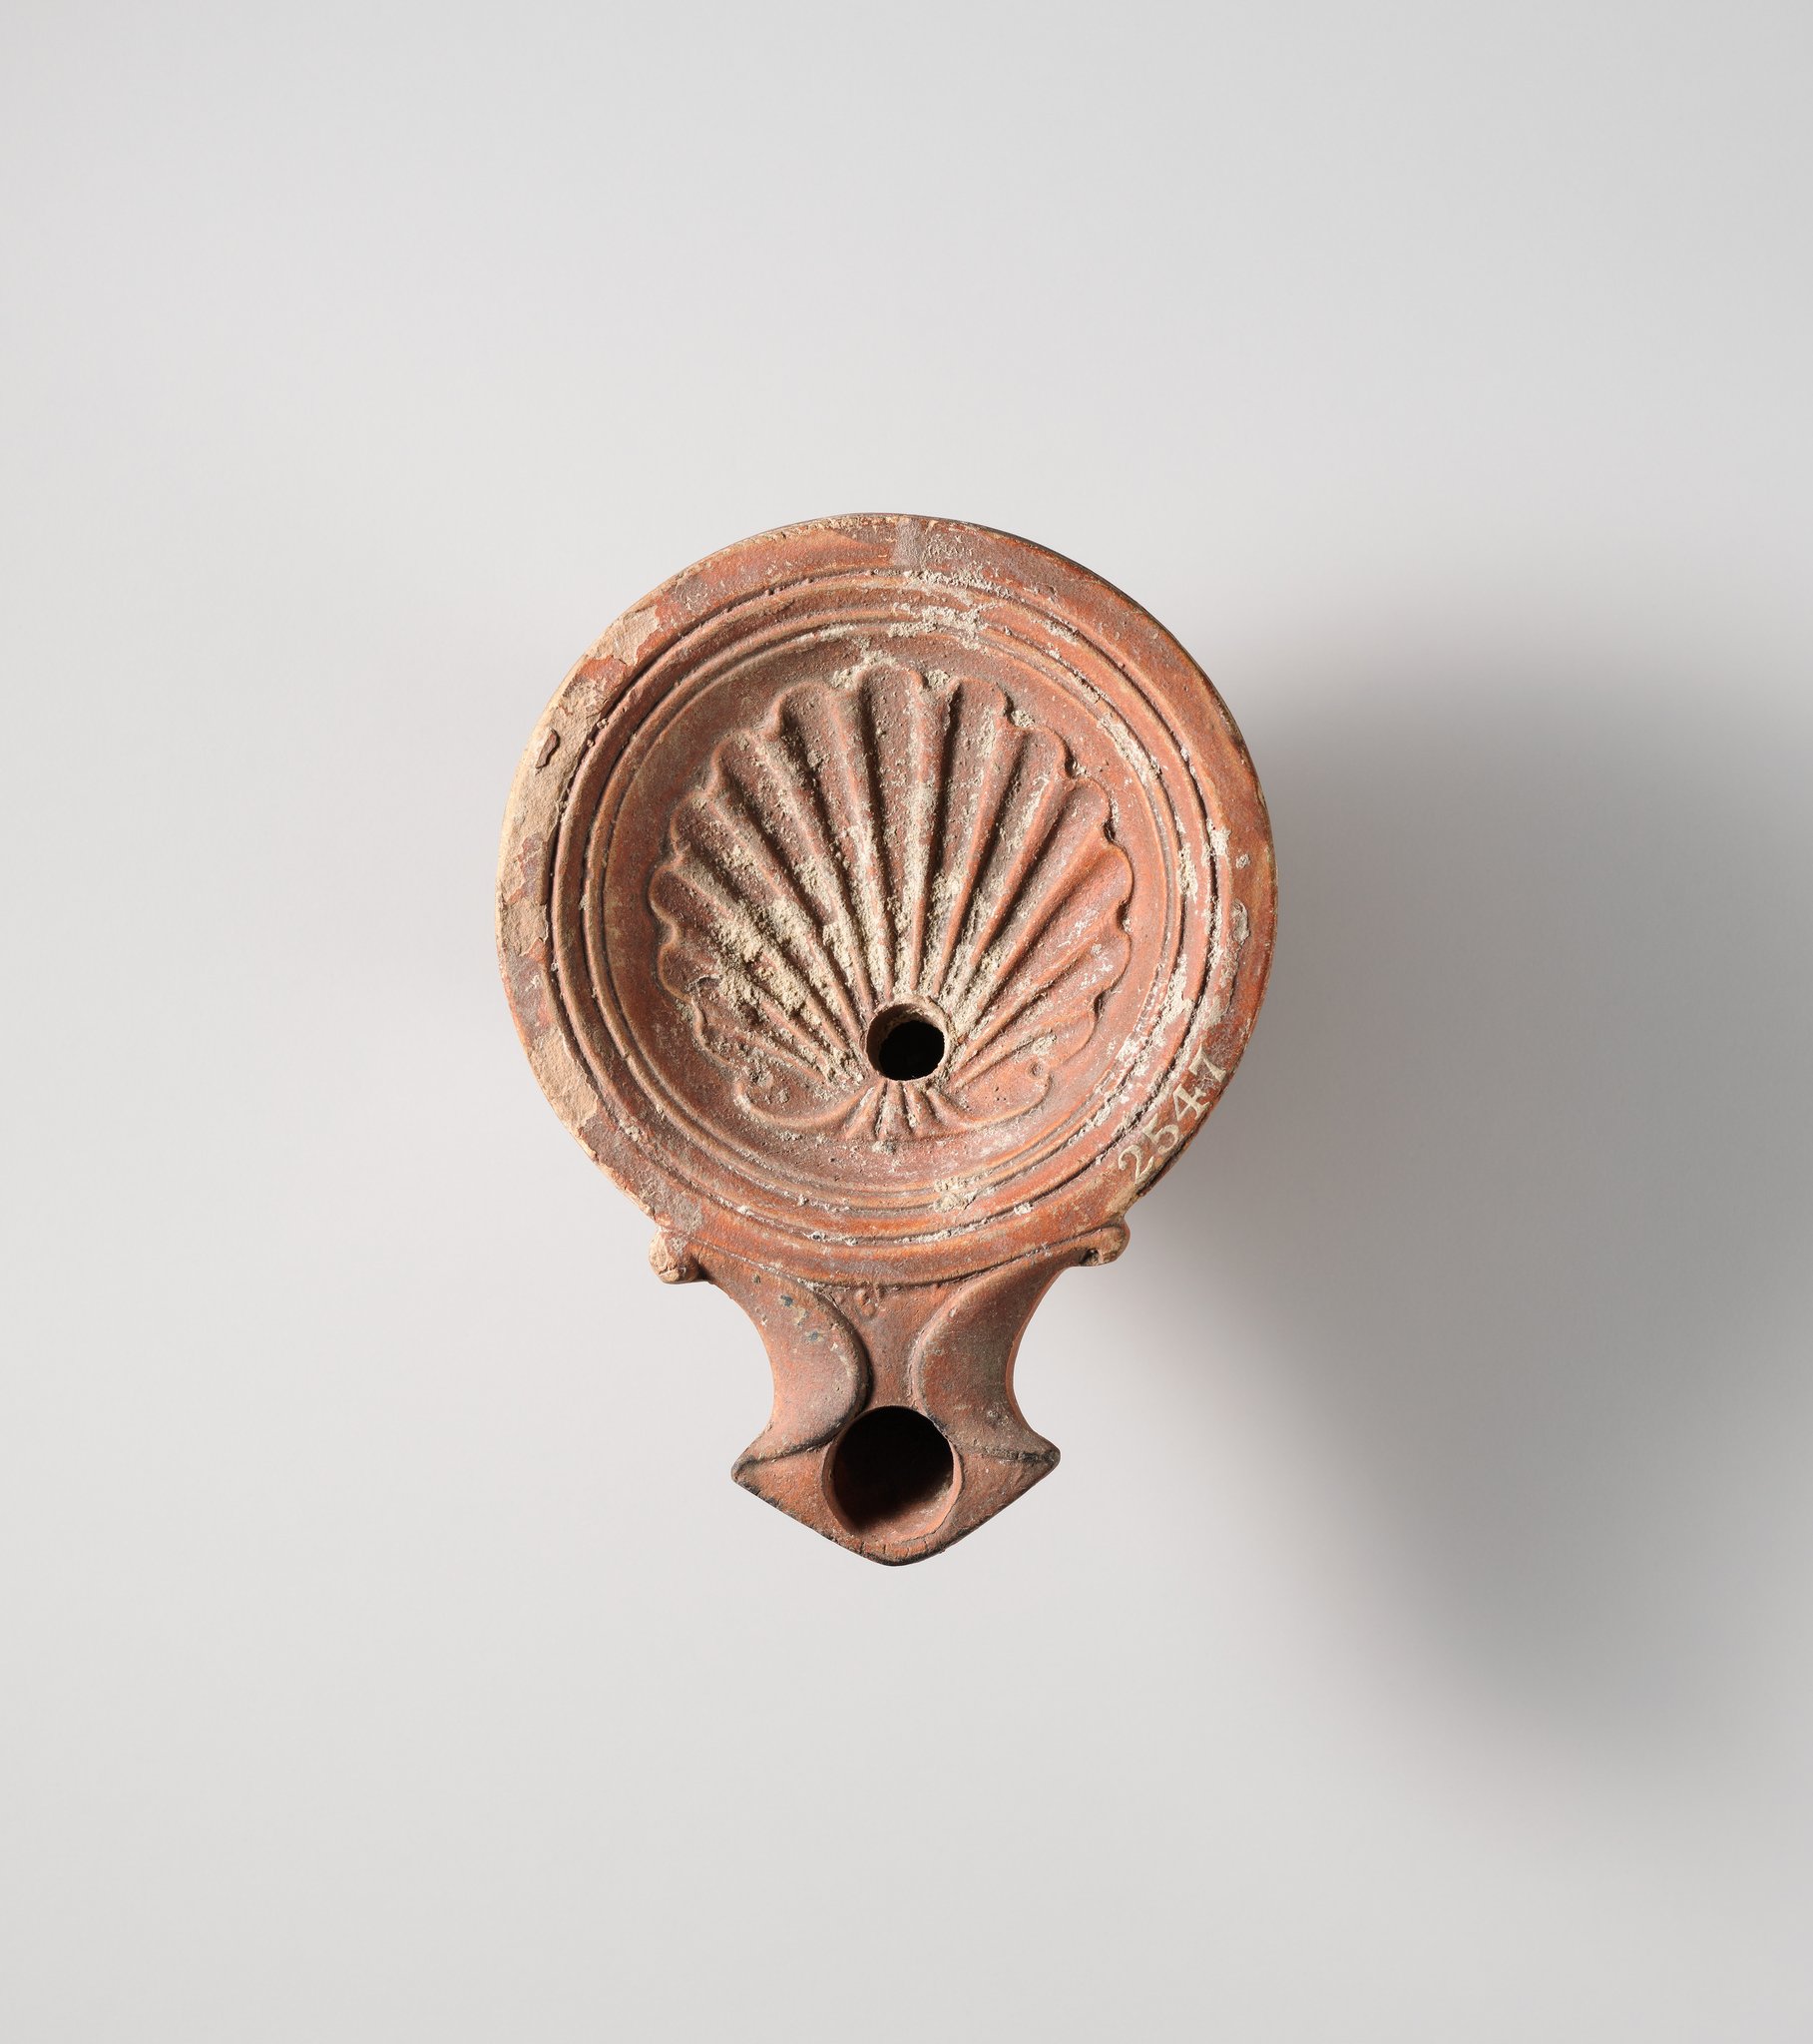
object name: lamp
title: Terracotta oil lamp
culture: roman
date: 100 BCE-100 CE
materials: terracotta